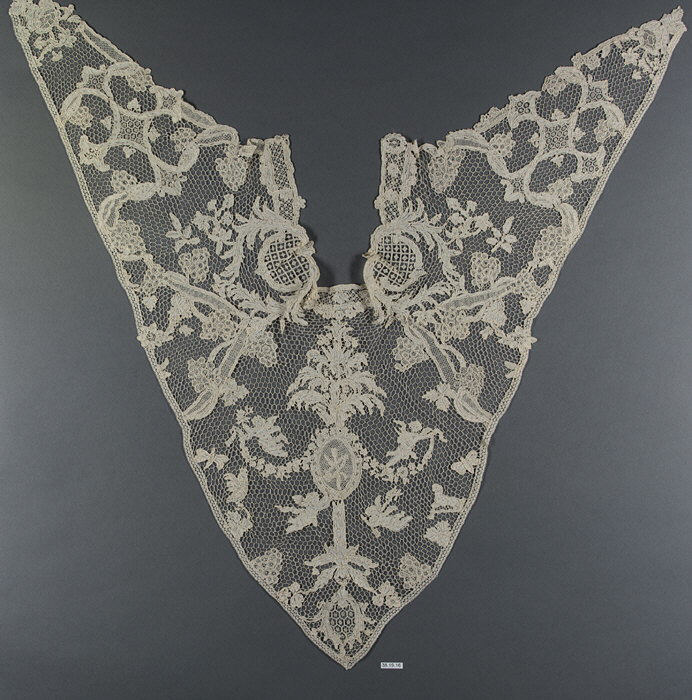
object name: gilet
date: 1701-1800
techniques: lace